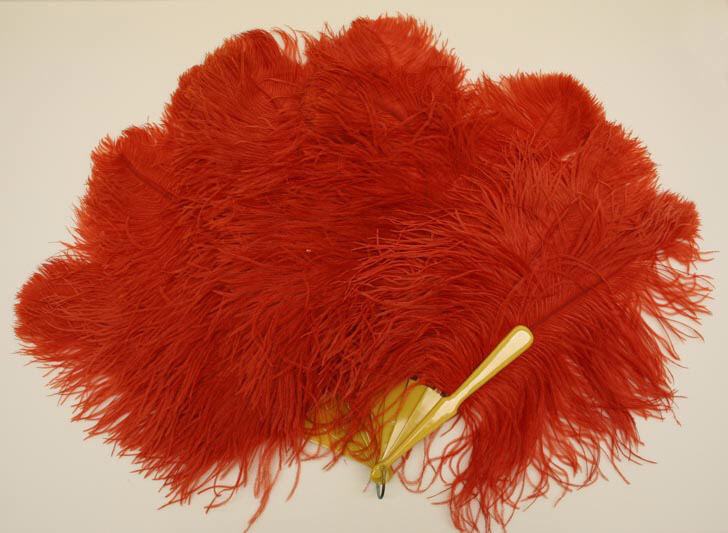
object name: fan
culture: american or european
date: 1890-1899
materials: feather, plastic